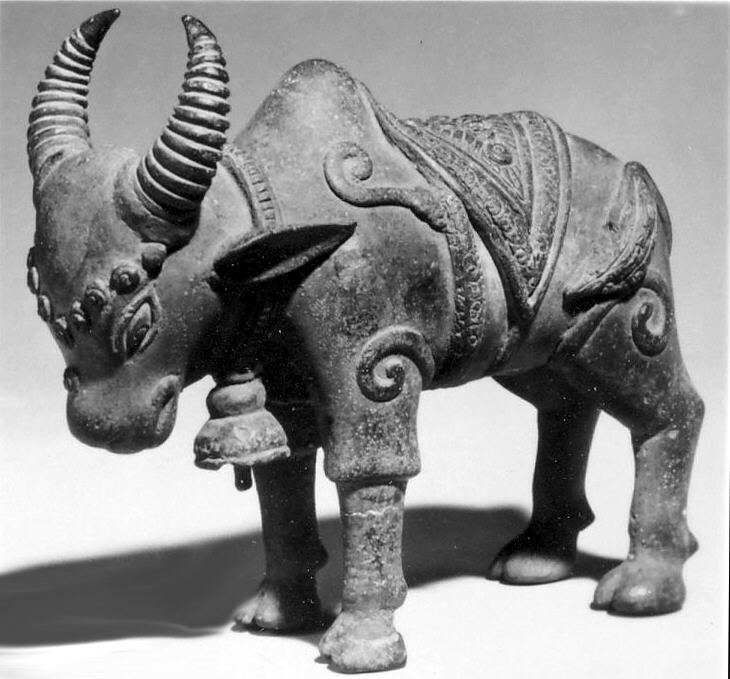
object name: figure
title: Toy Bull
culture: indonesian, javanese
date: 901-1100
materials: bronze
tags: bulls,toys